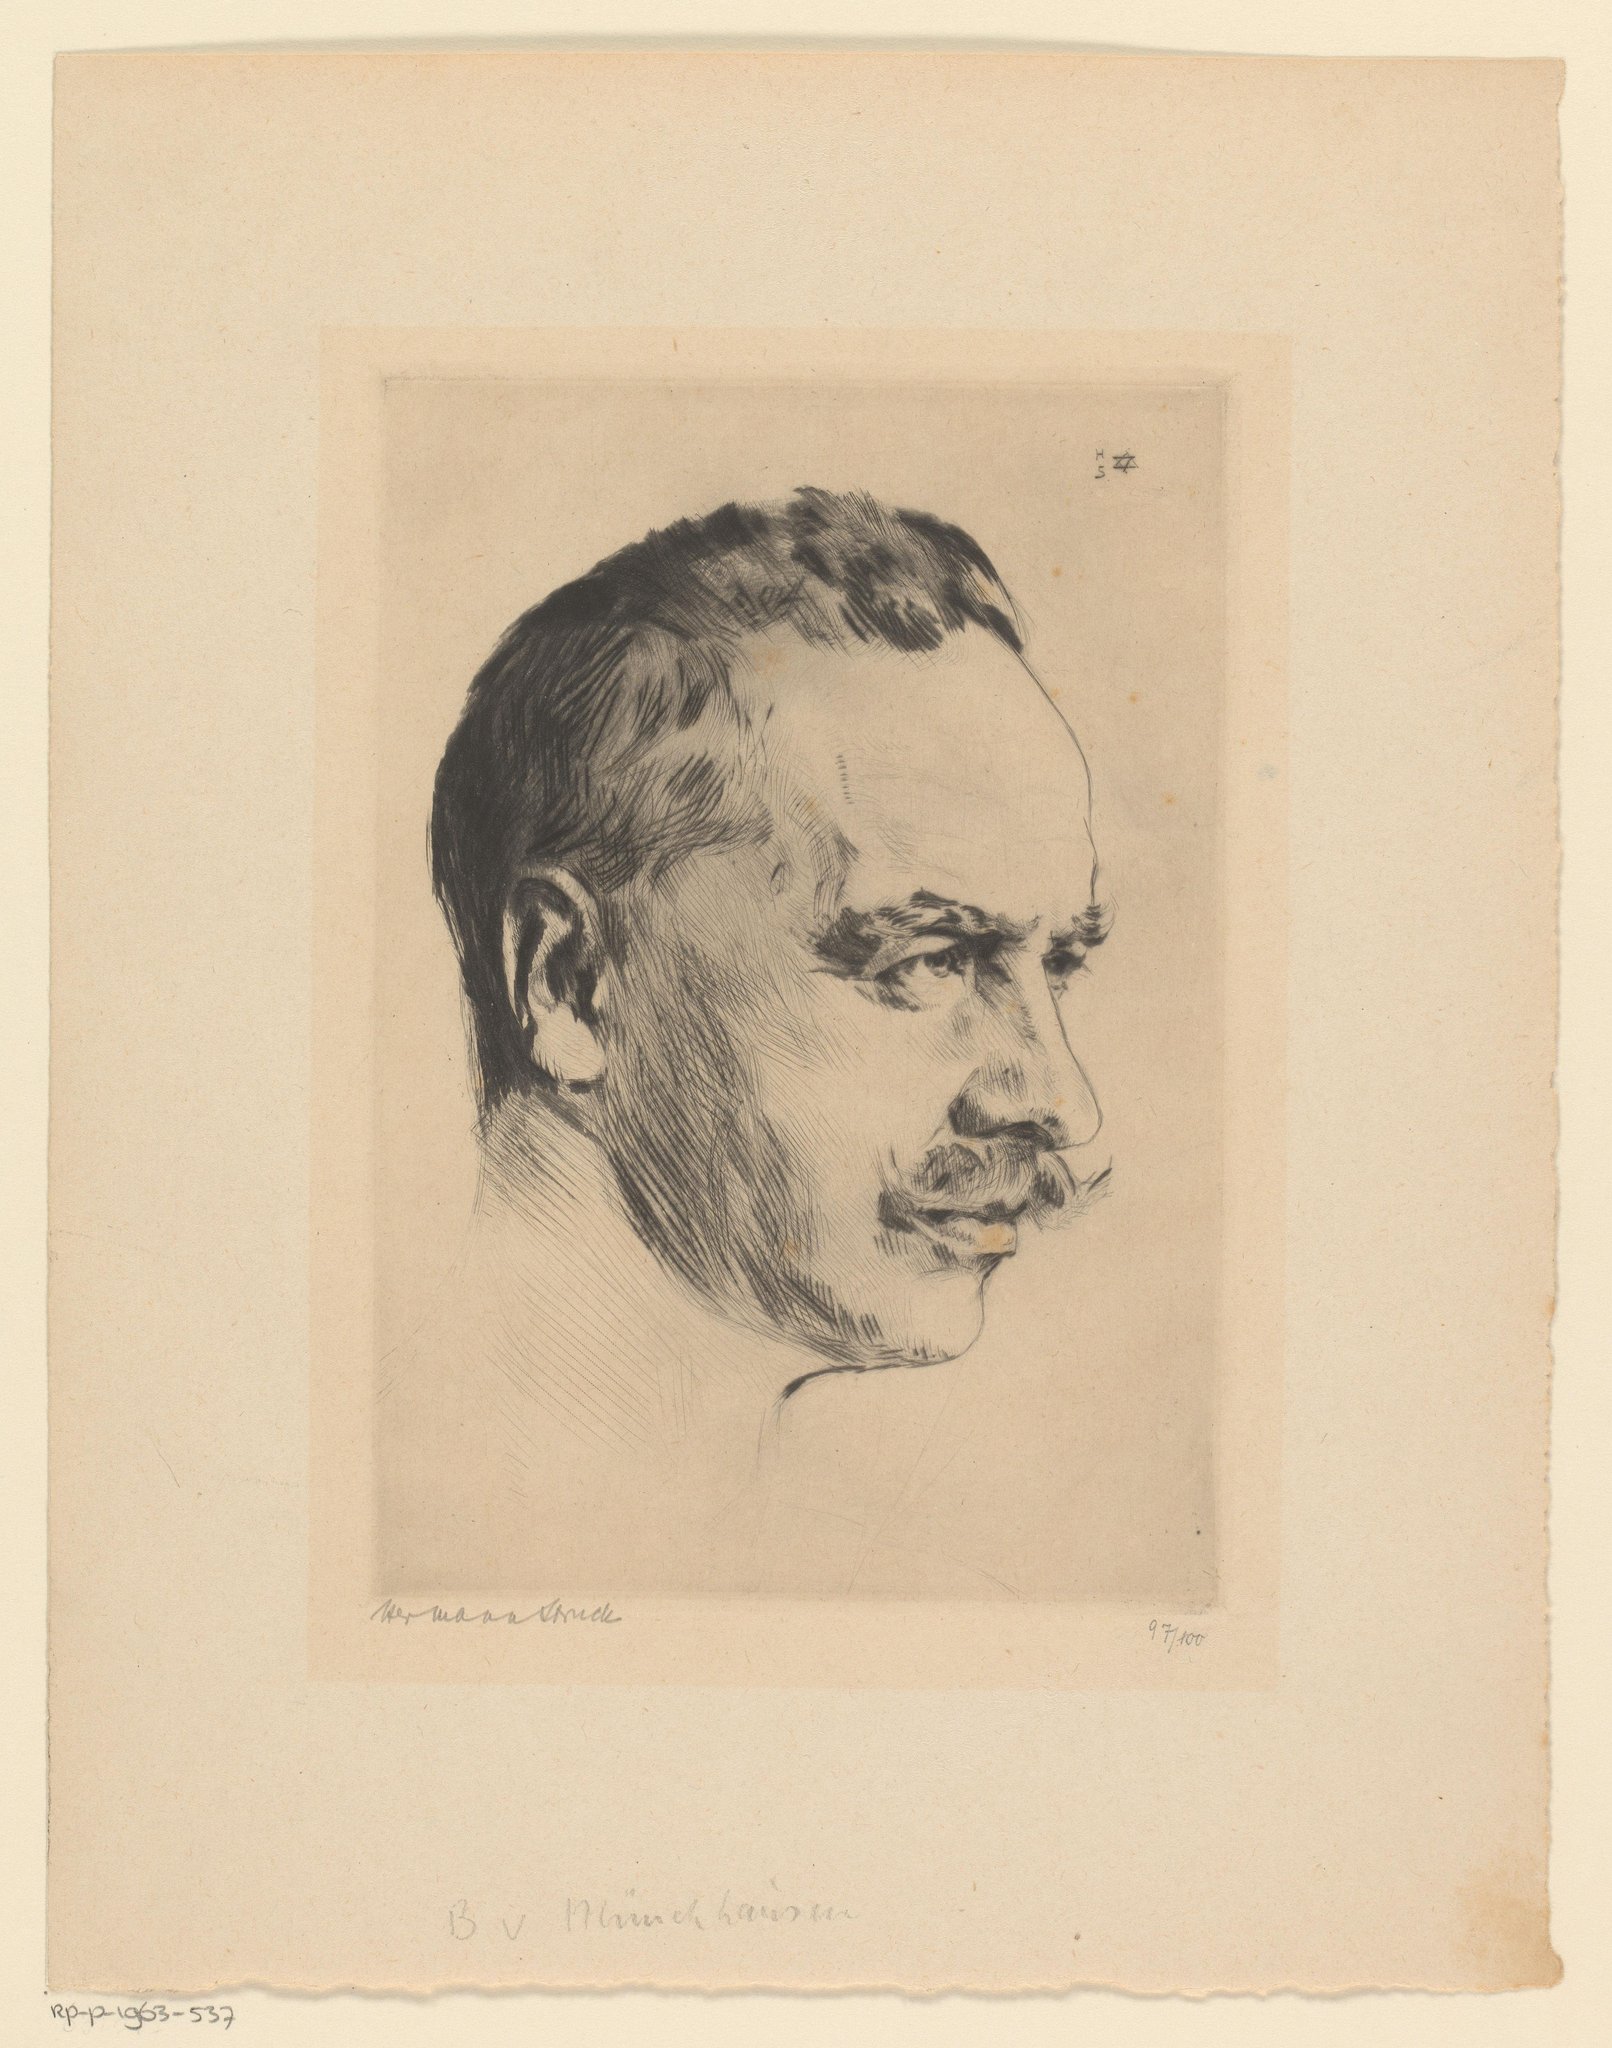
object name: print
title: Portret van Börries von Münchhausen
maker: hermann struck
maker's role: print maker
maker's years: 1876-1944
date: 1898-1944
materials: paper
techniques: etching, intaglio, retroussage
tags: börries von münchhausen, historical persons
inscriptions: collector's mark: Lugt 2228